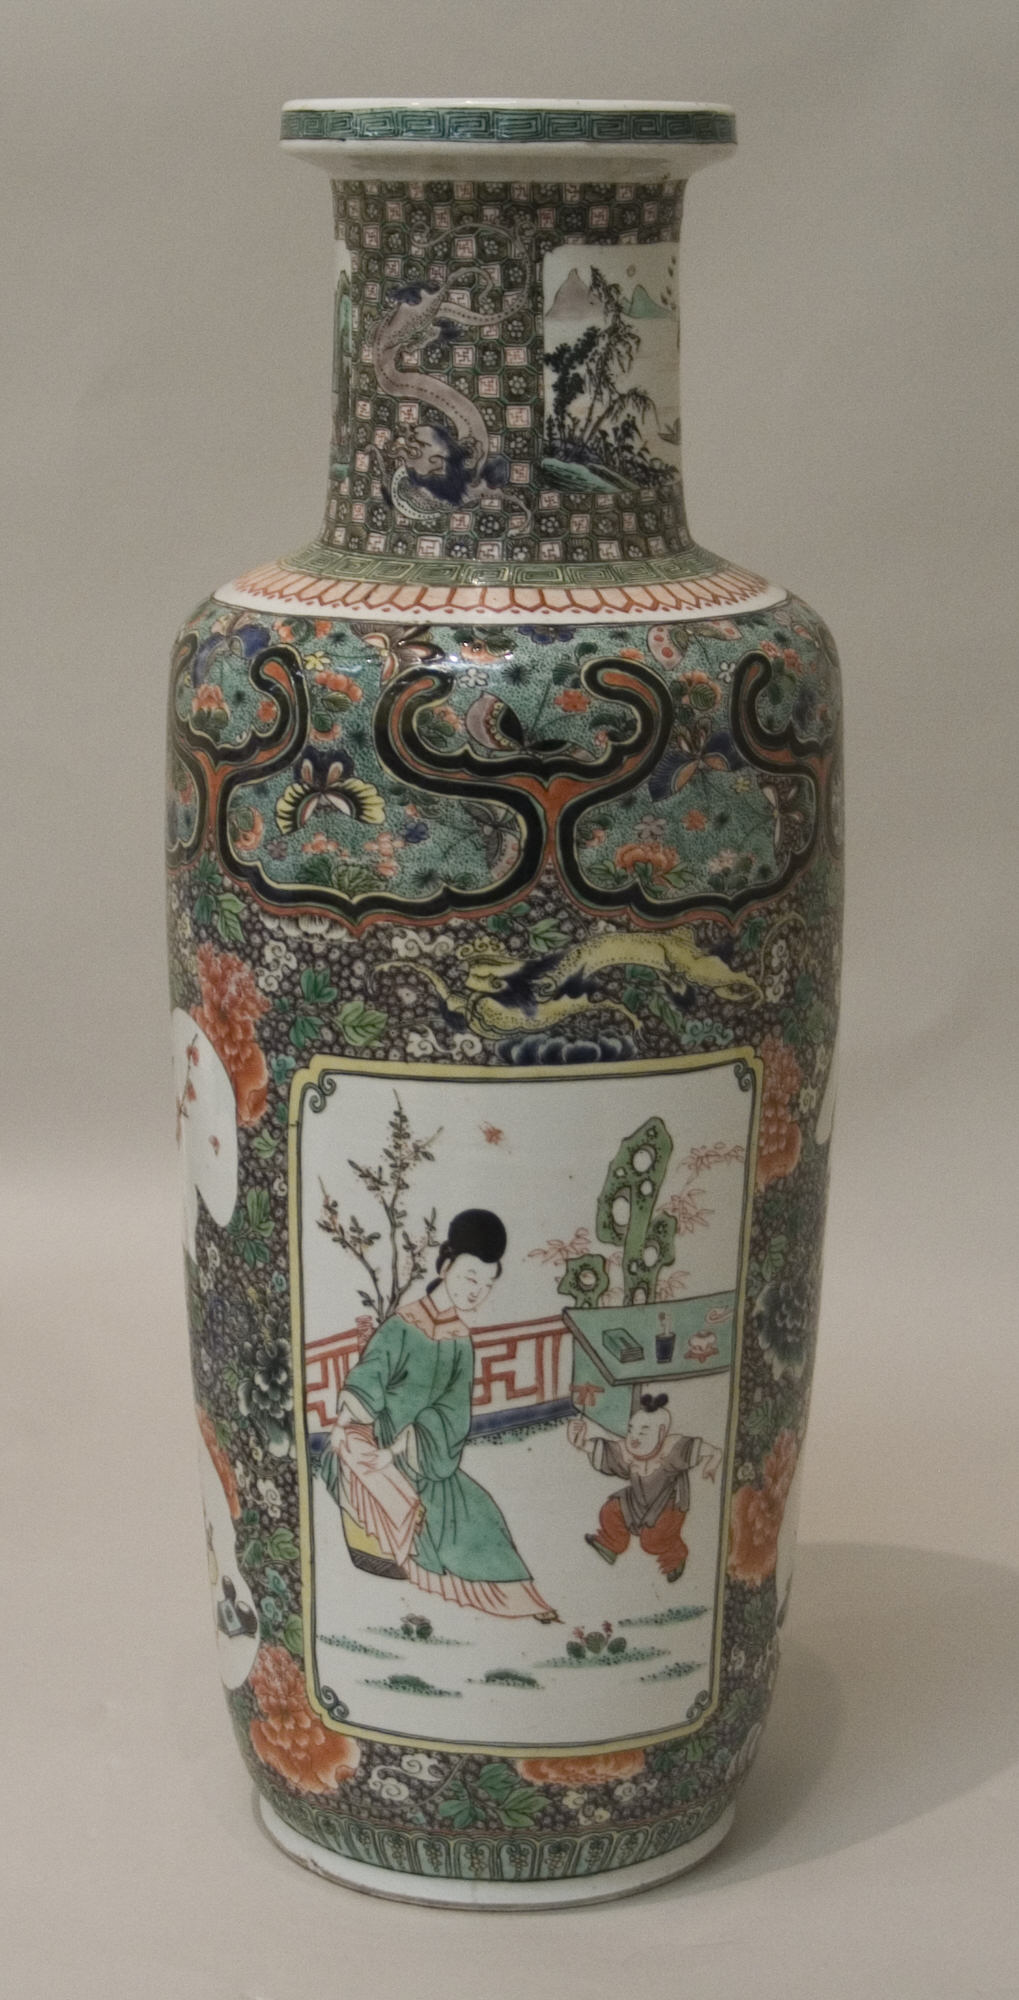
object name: vase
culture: chinese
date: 1667-1733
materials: enamel, porcelain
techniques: gilding, overglaze, painting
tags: boys,women,butterflies,flowers